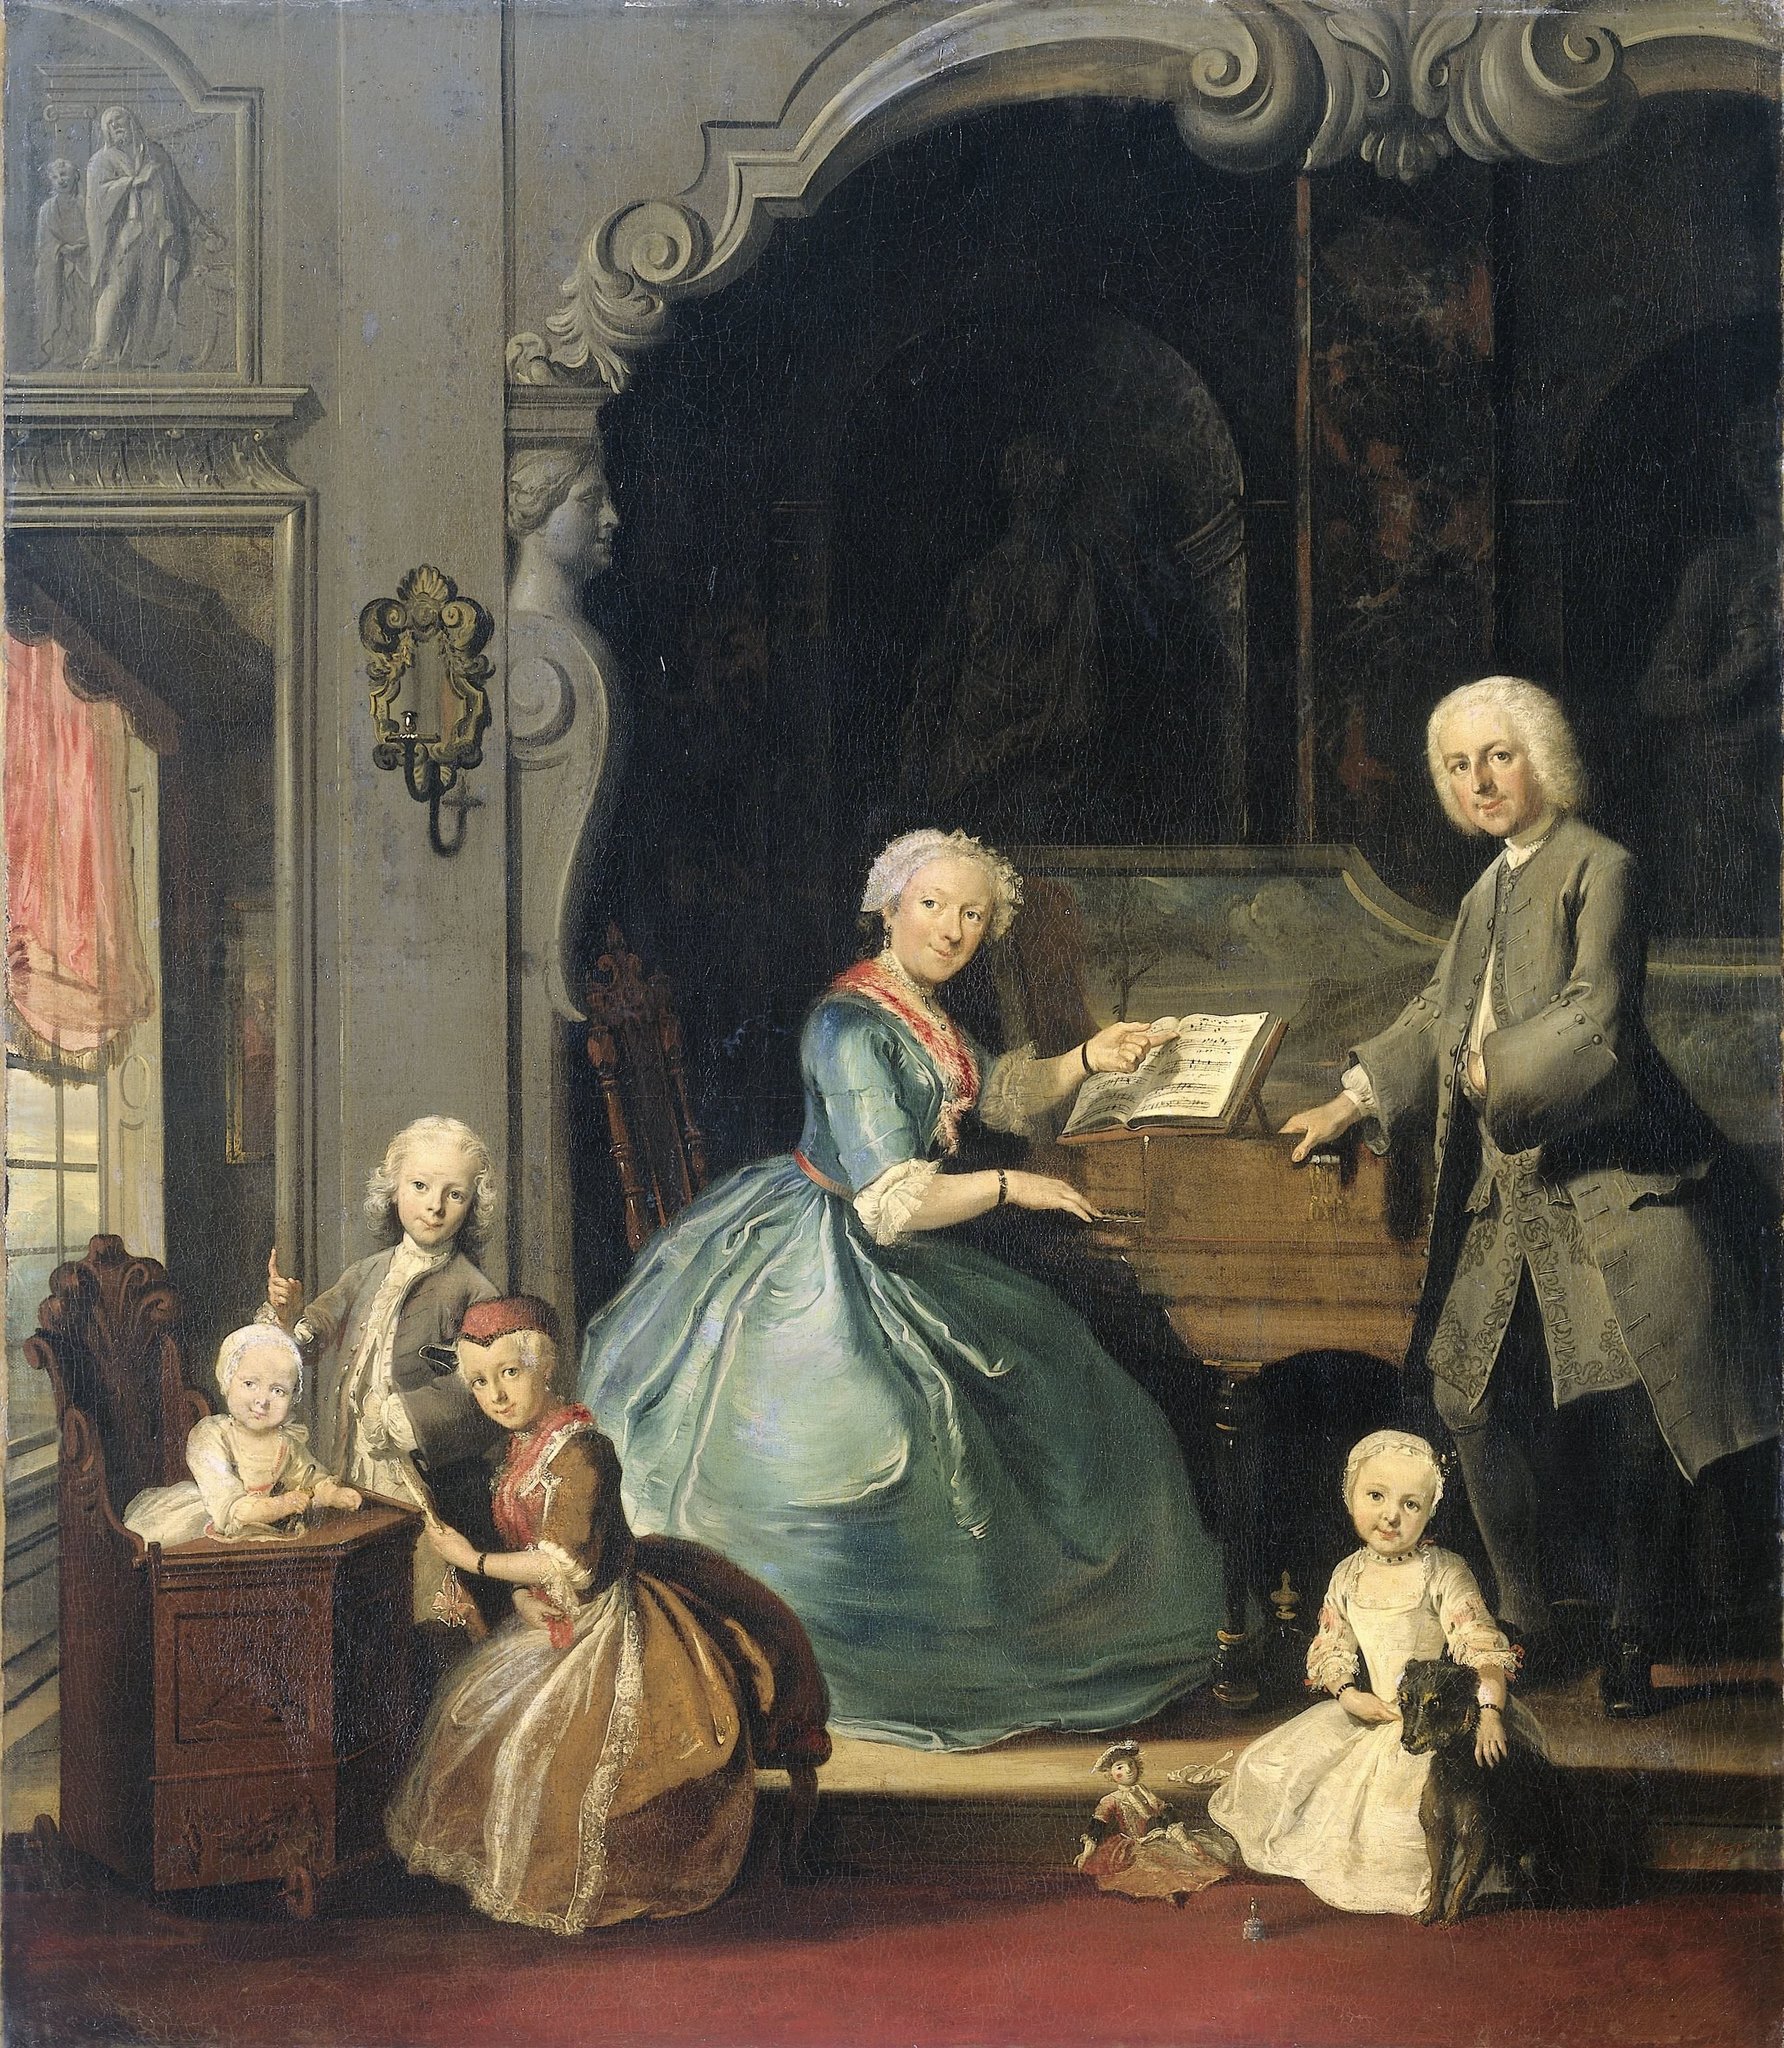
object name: painting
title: Family Group near a Harpsichord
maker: cornelis troost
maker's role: draughtsman, painter, print maker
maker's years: 1696-1750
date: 1739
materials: canvas, oil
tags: instrumental and vocal music together, baby-chair, family group, especially parents with their child(ren), (playing with) dolls, clavichord, harpsichord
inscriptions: signature and date: ‘C. Troost 1739’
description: Troost was a master of the informal group portrait. It is as if everyone had momentarily stopped what he or she was doing to look up as the artist entered. The house is decorated in the style of the time: the stuccowork above the door has a scene from Classical antiquity and ancient statues fill the marble niches behind the harpsichord.